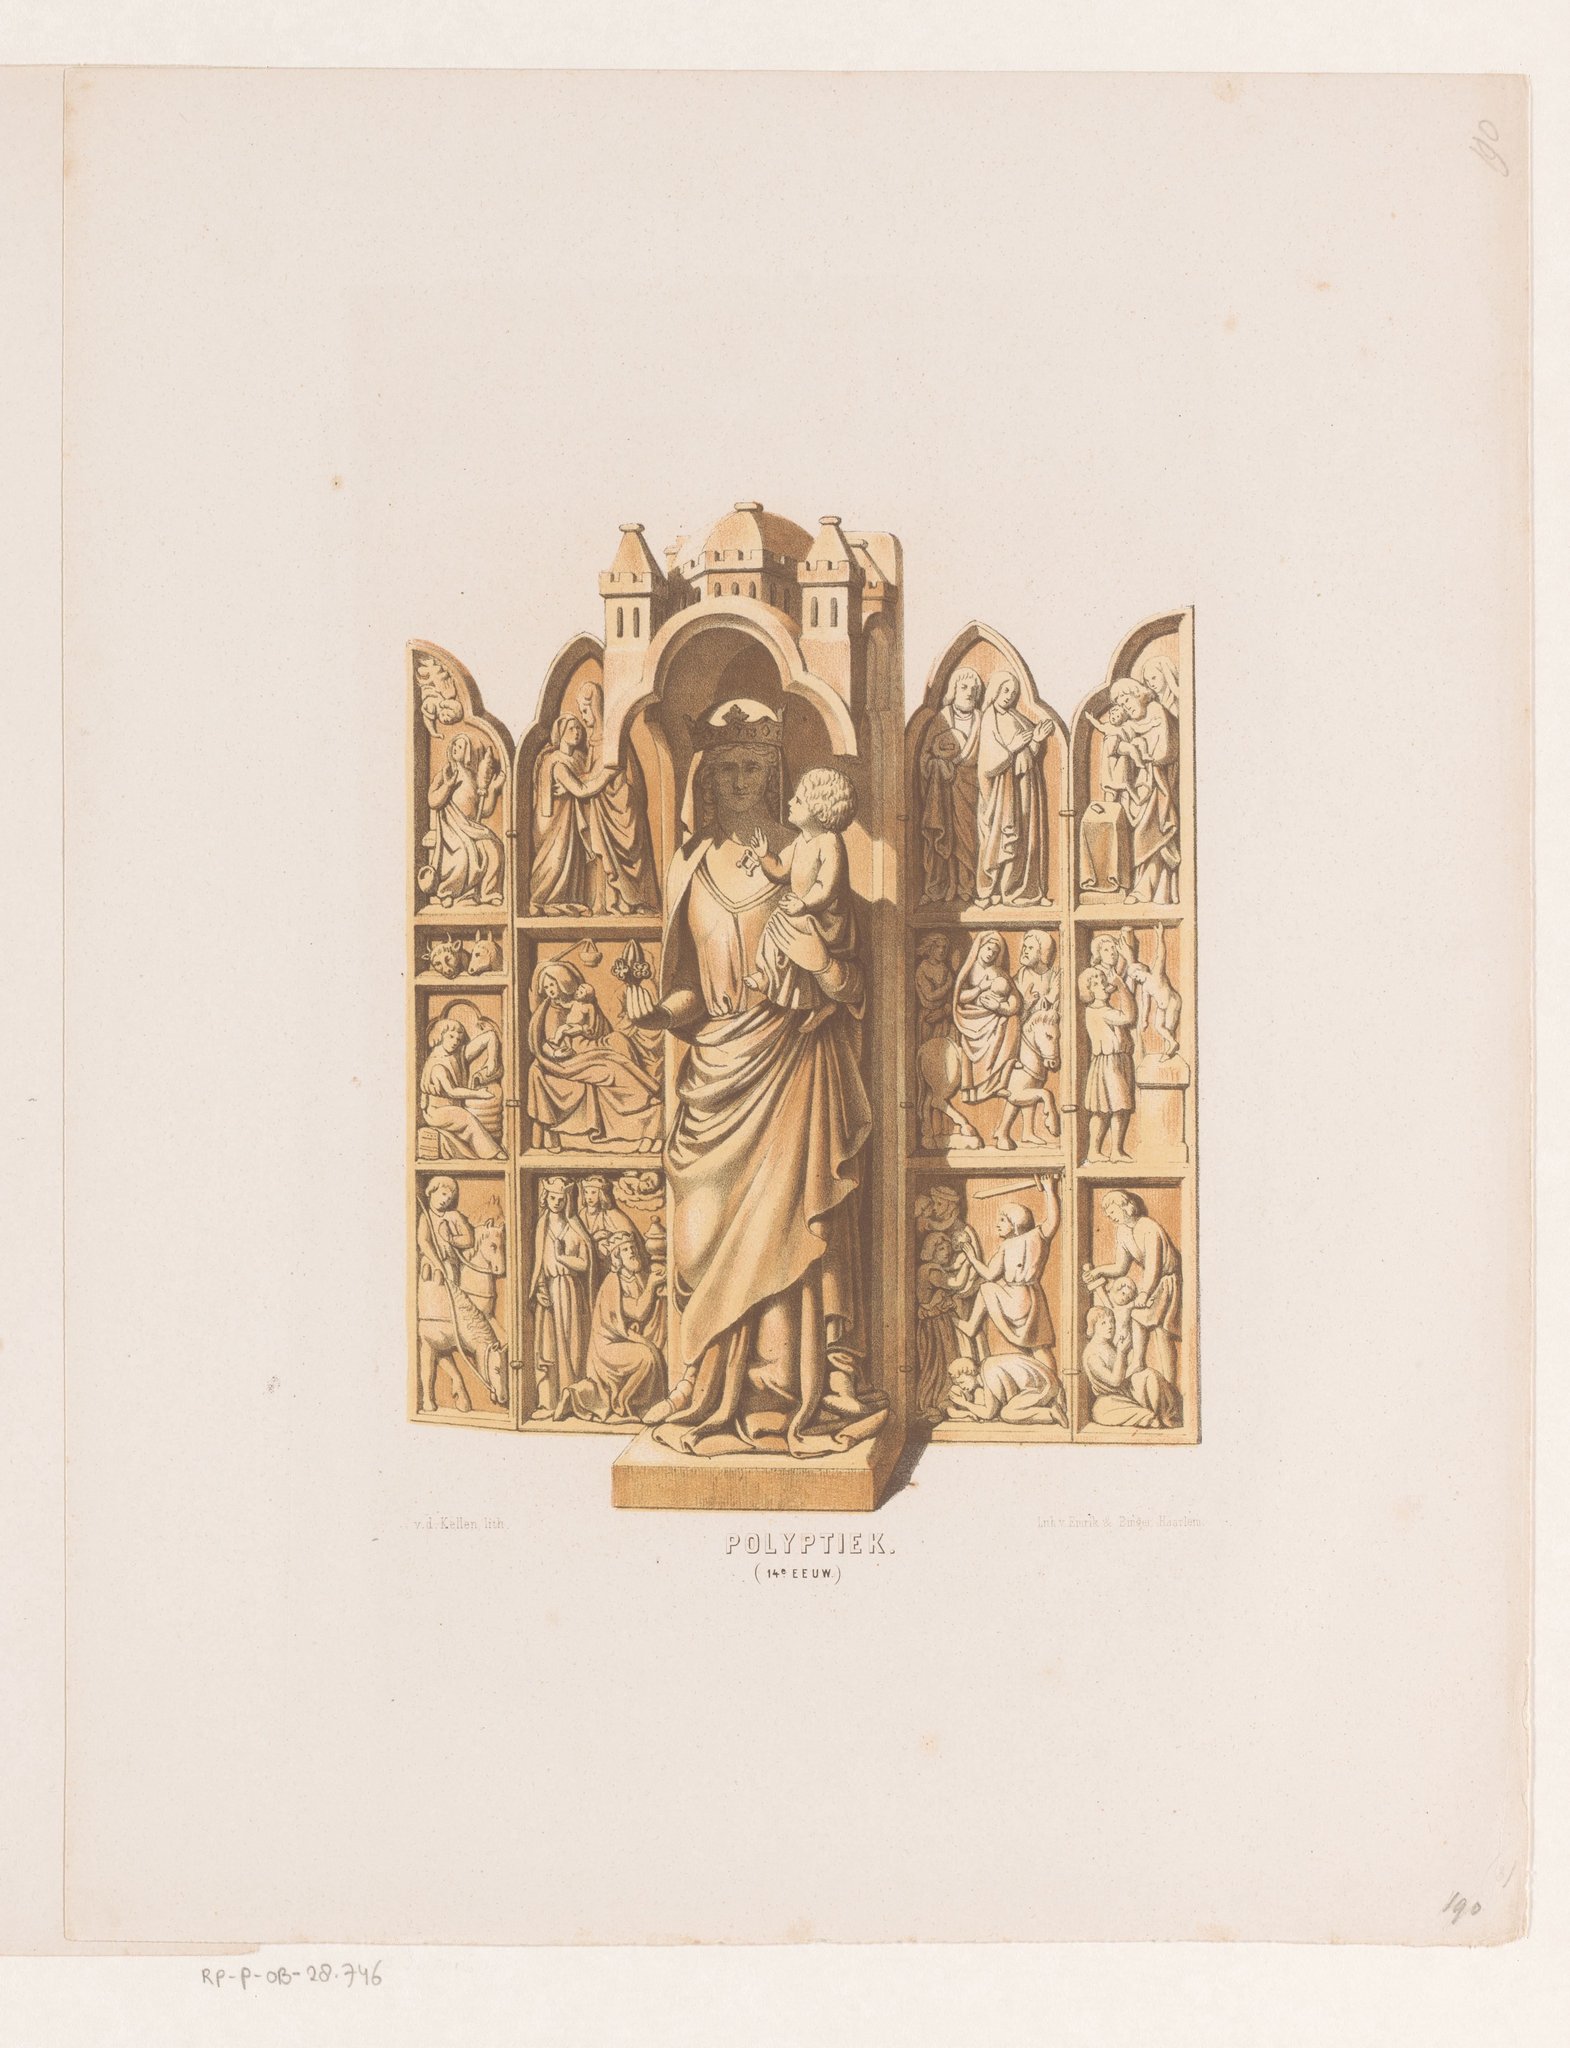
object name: print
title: Polyptiek. (14e eeuw)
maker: david van der kellen (1827-1895)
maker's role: draughtsman, print maker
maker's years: 1827-1895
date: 1857-1864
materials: paper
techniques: tone lithography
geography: haarlem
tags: piece of sculpture, reproduction of a piece of sculpture, monument, statue, netherlands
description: Drieluik met snijwerk, 14e eeuw. Centraal Maria met kind, in de twee zijluiken scènes uit het verhaal van de geboorte van Christus.